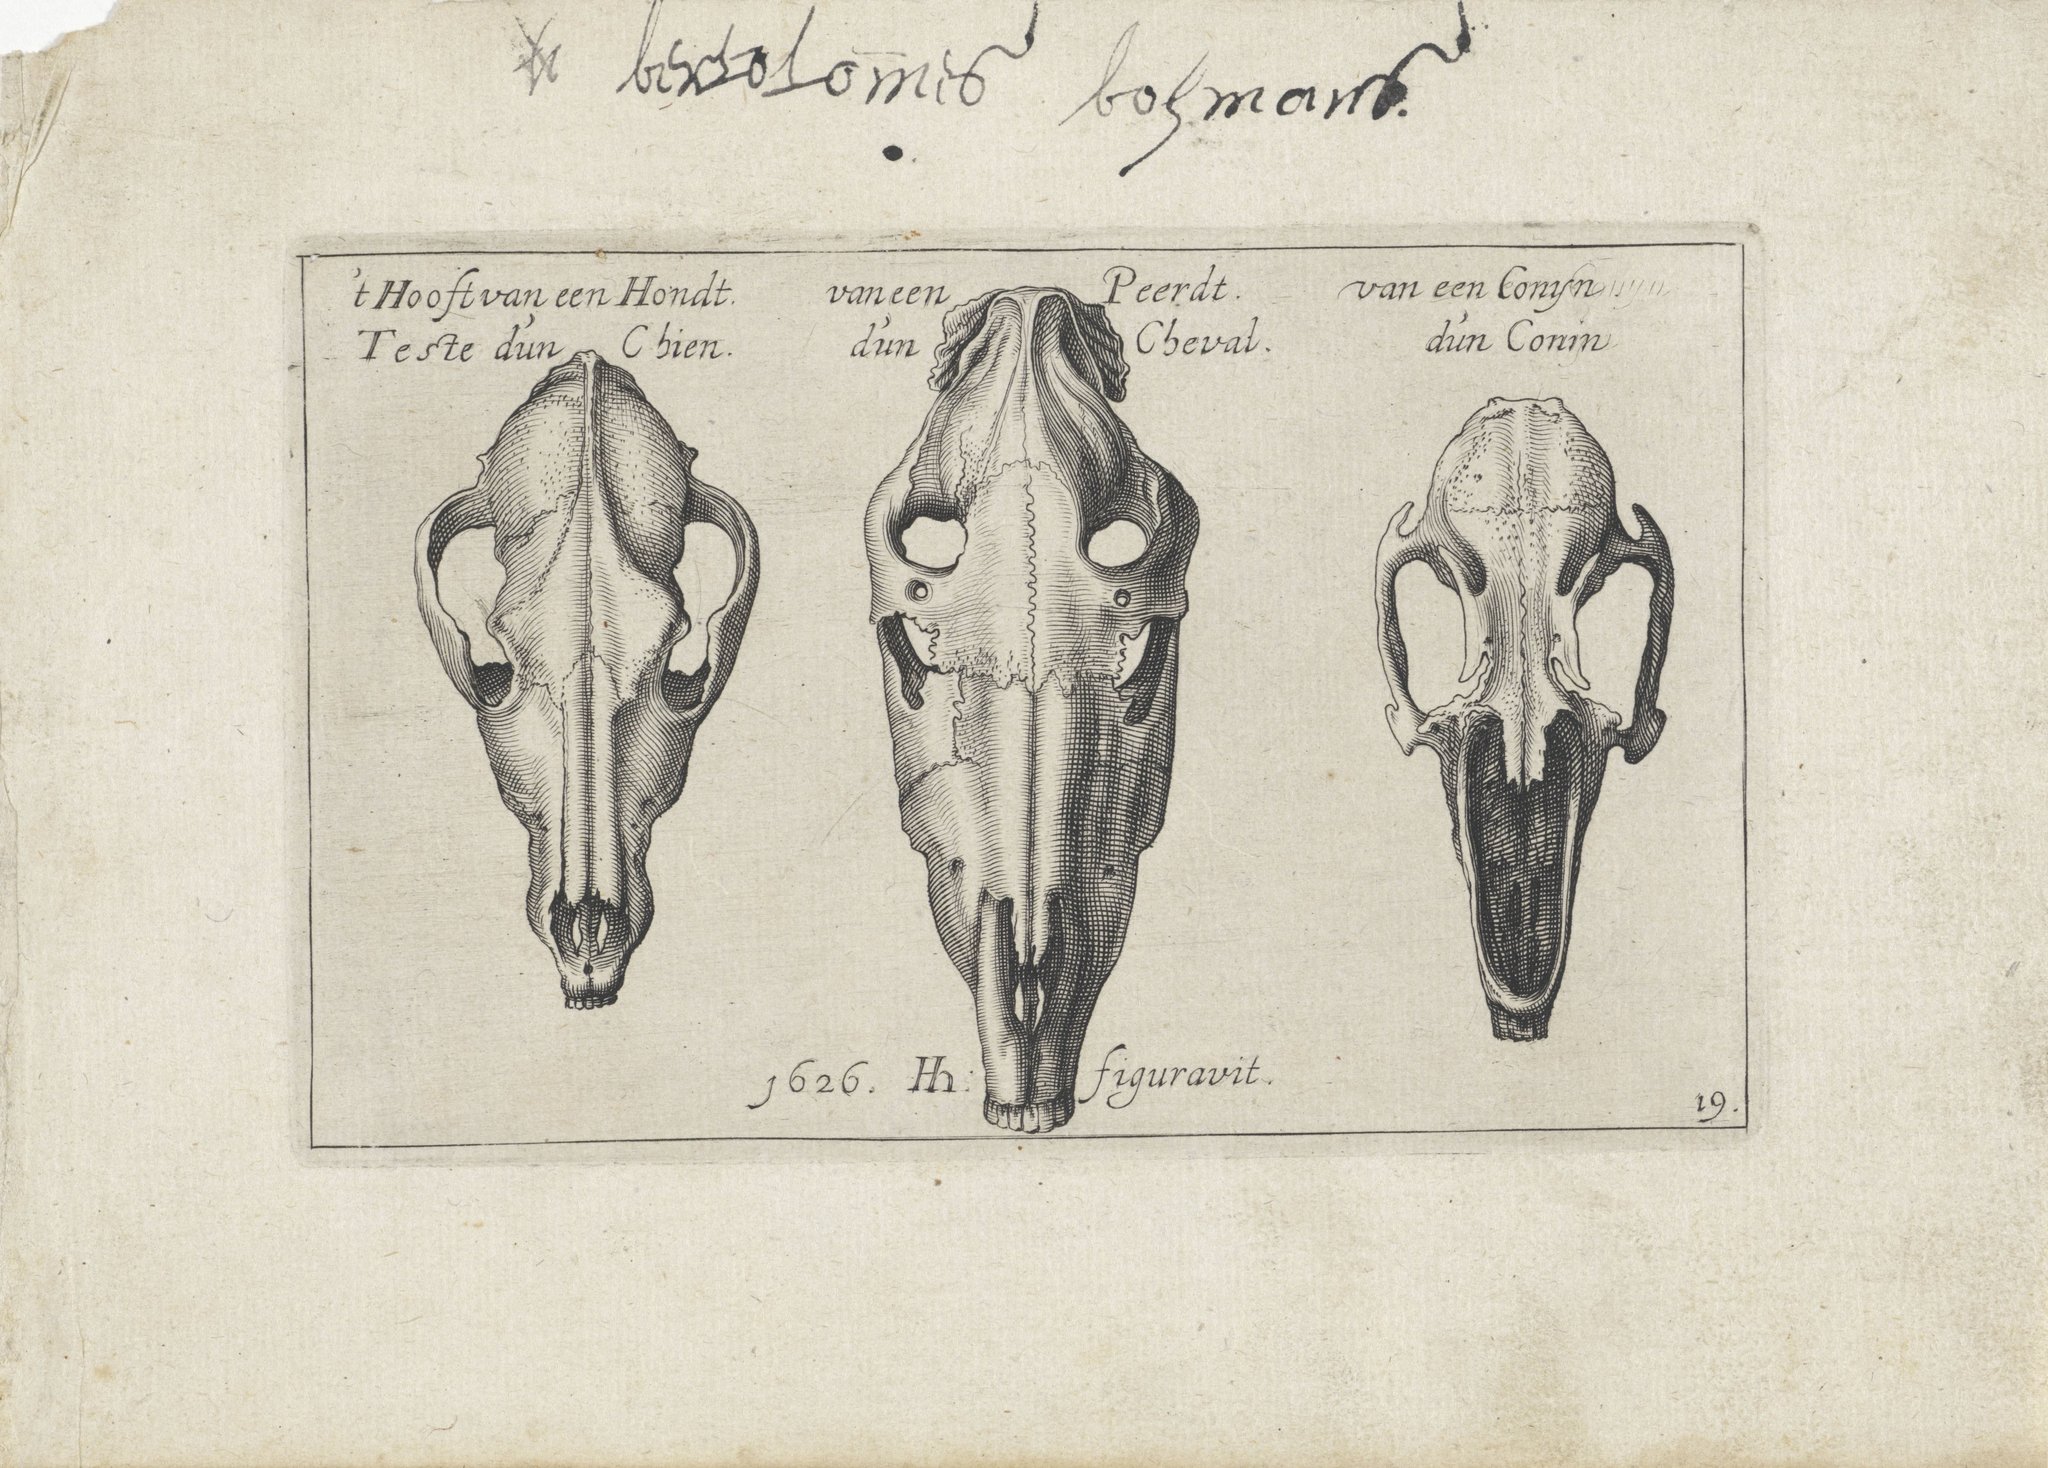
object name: print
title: Dierskeletten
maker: hendrick hondius (i)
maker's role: draughtsman, print maker, publisher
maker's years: 1573-1650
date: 1626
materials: paper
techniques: engraving, etching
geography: the hague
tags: horse (+ skull of an animal), dog (+ skull of an animal), rodents: rabbit (+ skull of an animal)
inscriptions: collector's mark: Lugt 2228, inscription: ‘l.b.: 'Hooft van een Hondt / Teste d'un Chien // m.b. van een Peerdt / d'un Cheval // r.b.: van een Conijn / d'un Conin. l.o. 19’, signature and date: ‘m.o.: 1626 Hh figuravit’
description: Drie skeletten van dierenkoppen: links een hondenkop, in het midden een paardekop, rechts de kop van een konijn.